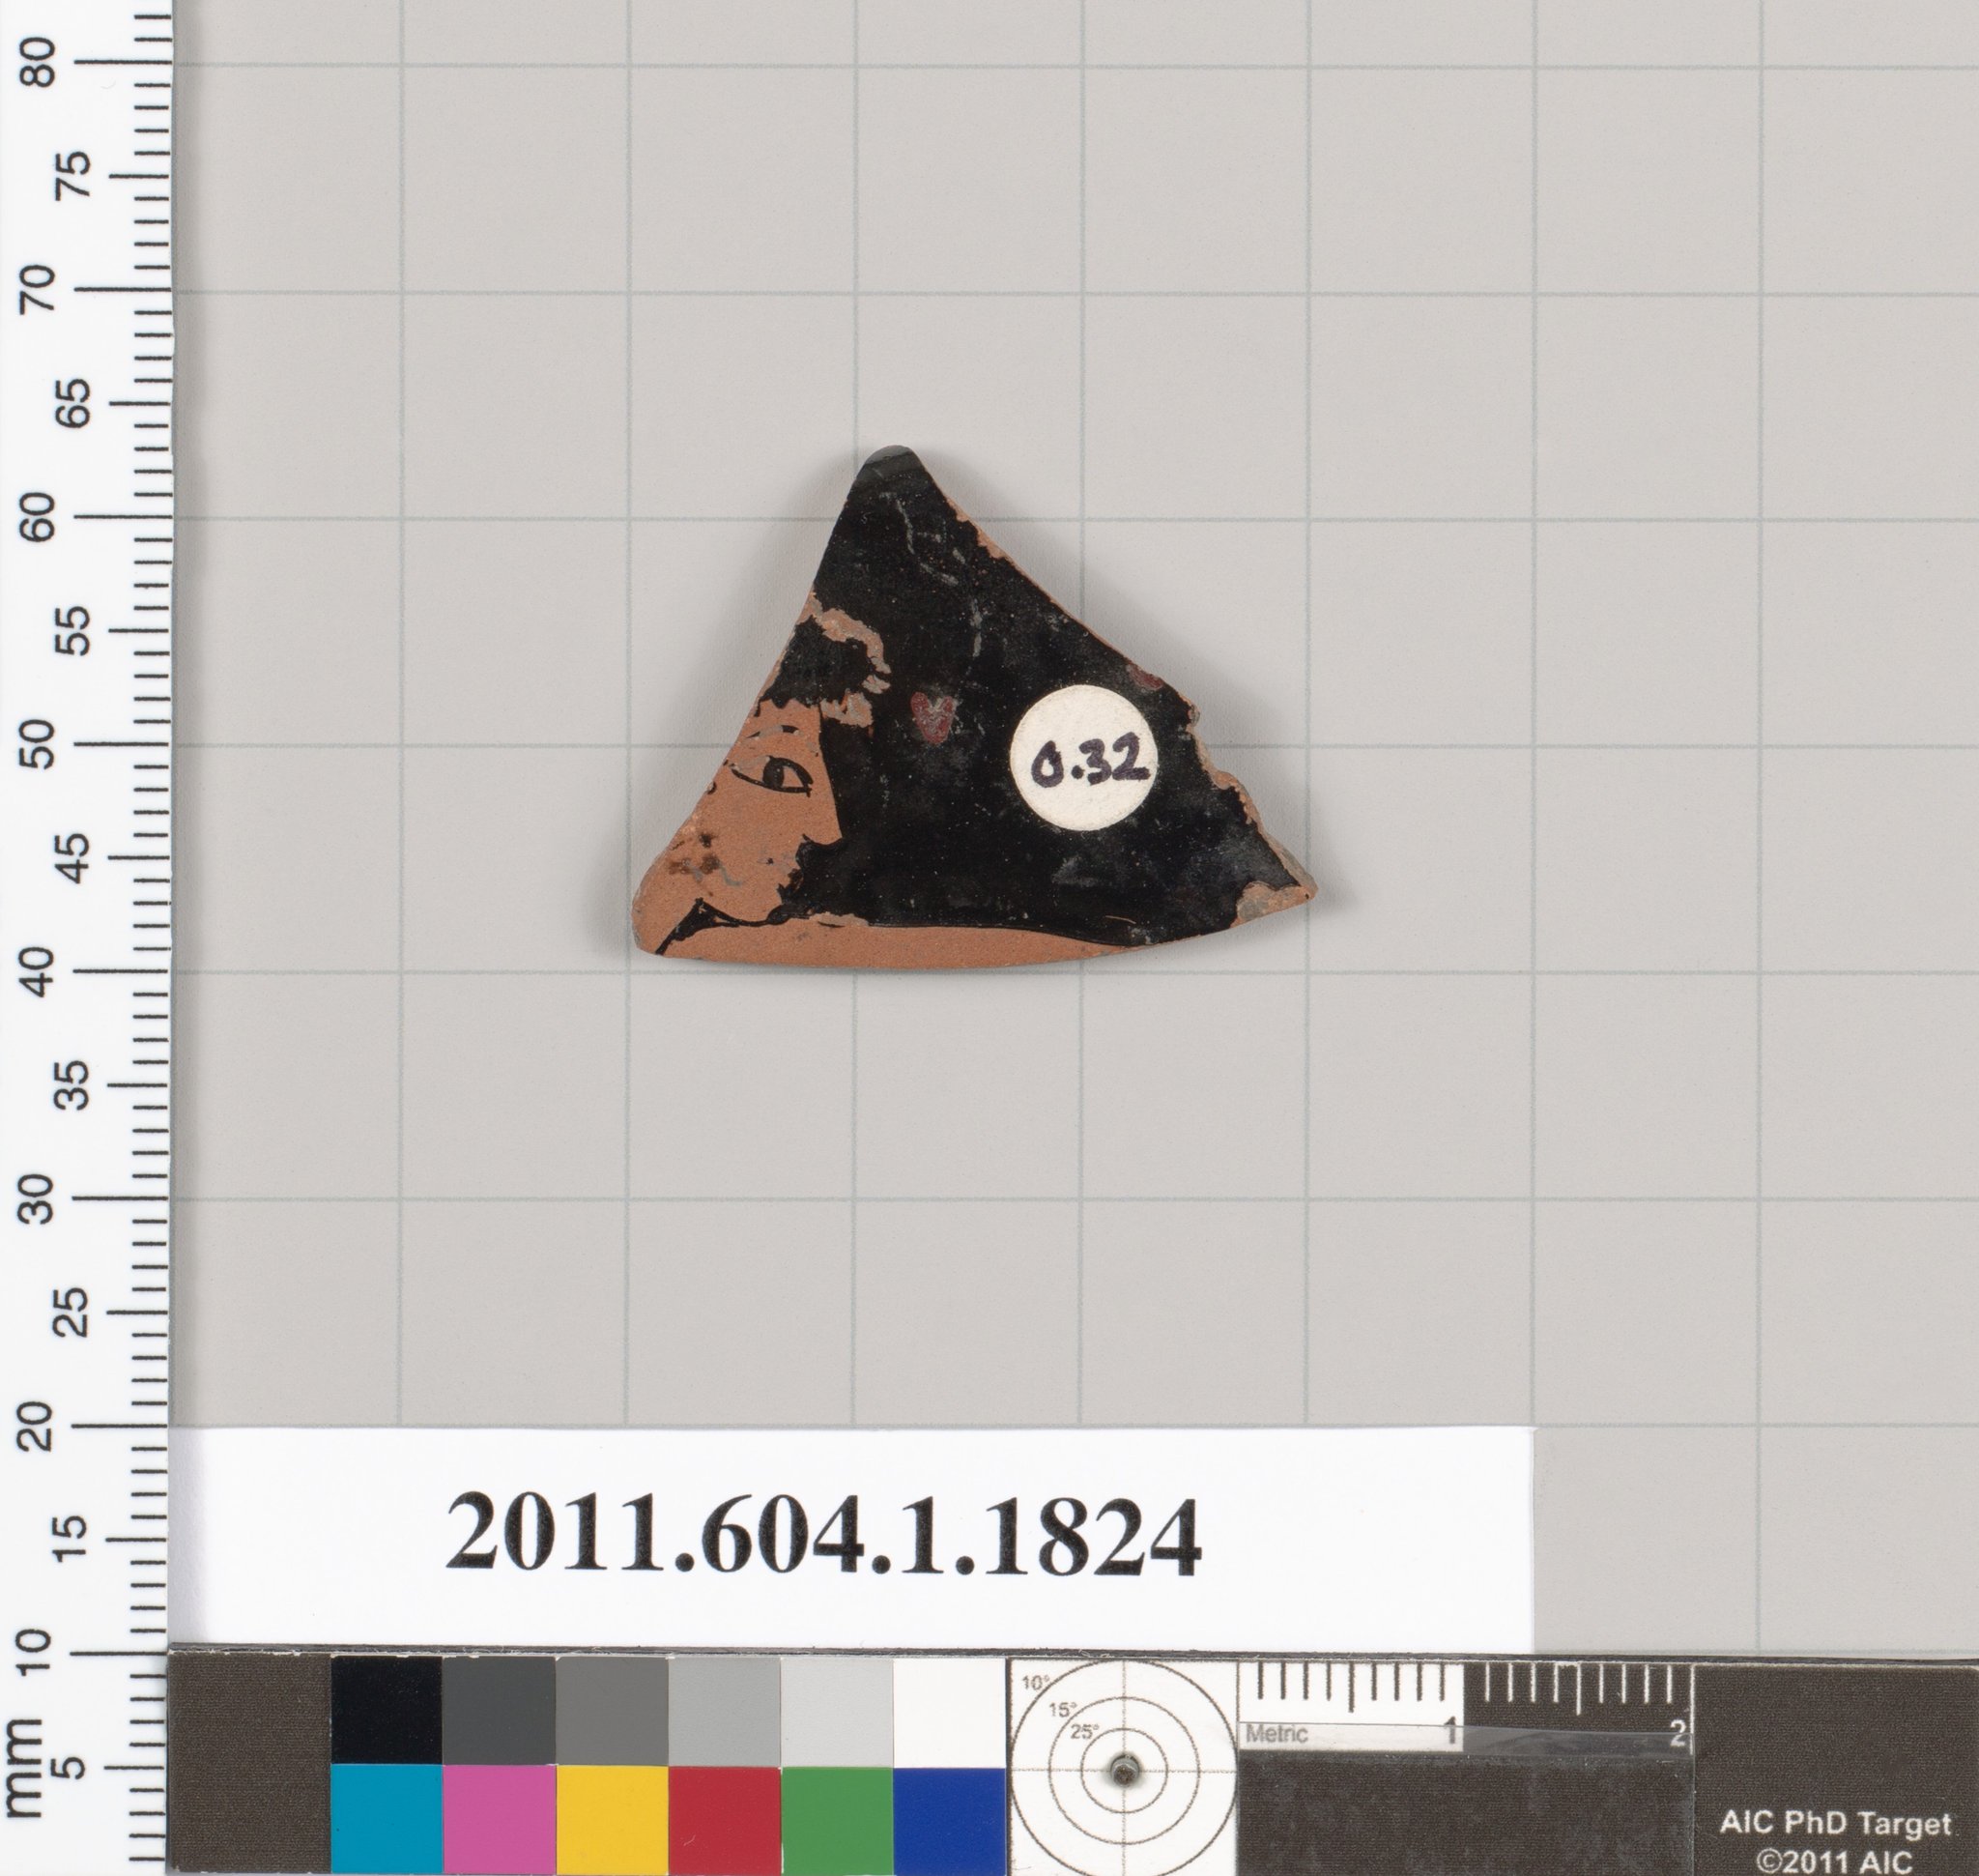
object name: kylix fragment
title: Terracotta rim fragment of a kylix (drinking cup)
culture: greek, attic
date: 510-500 BCE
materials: terracotta